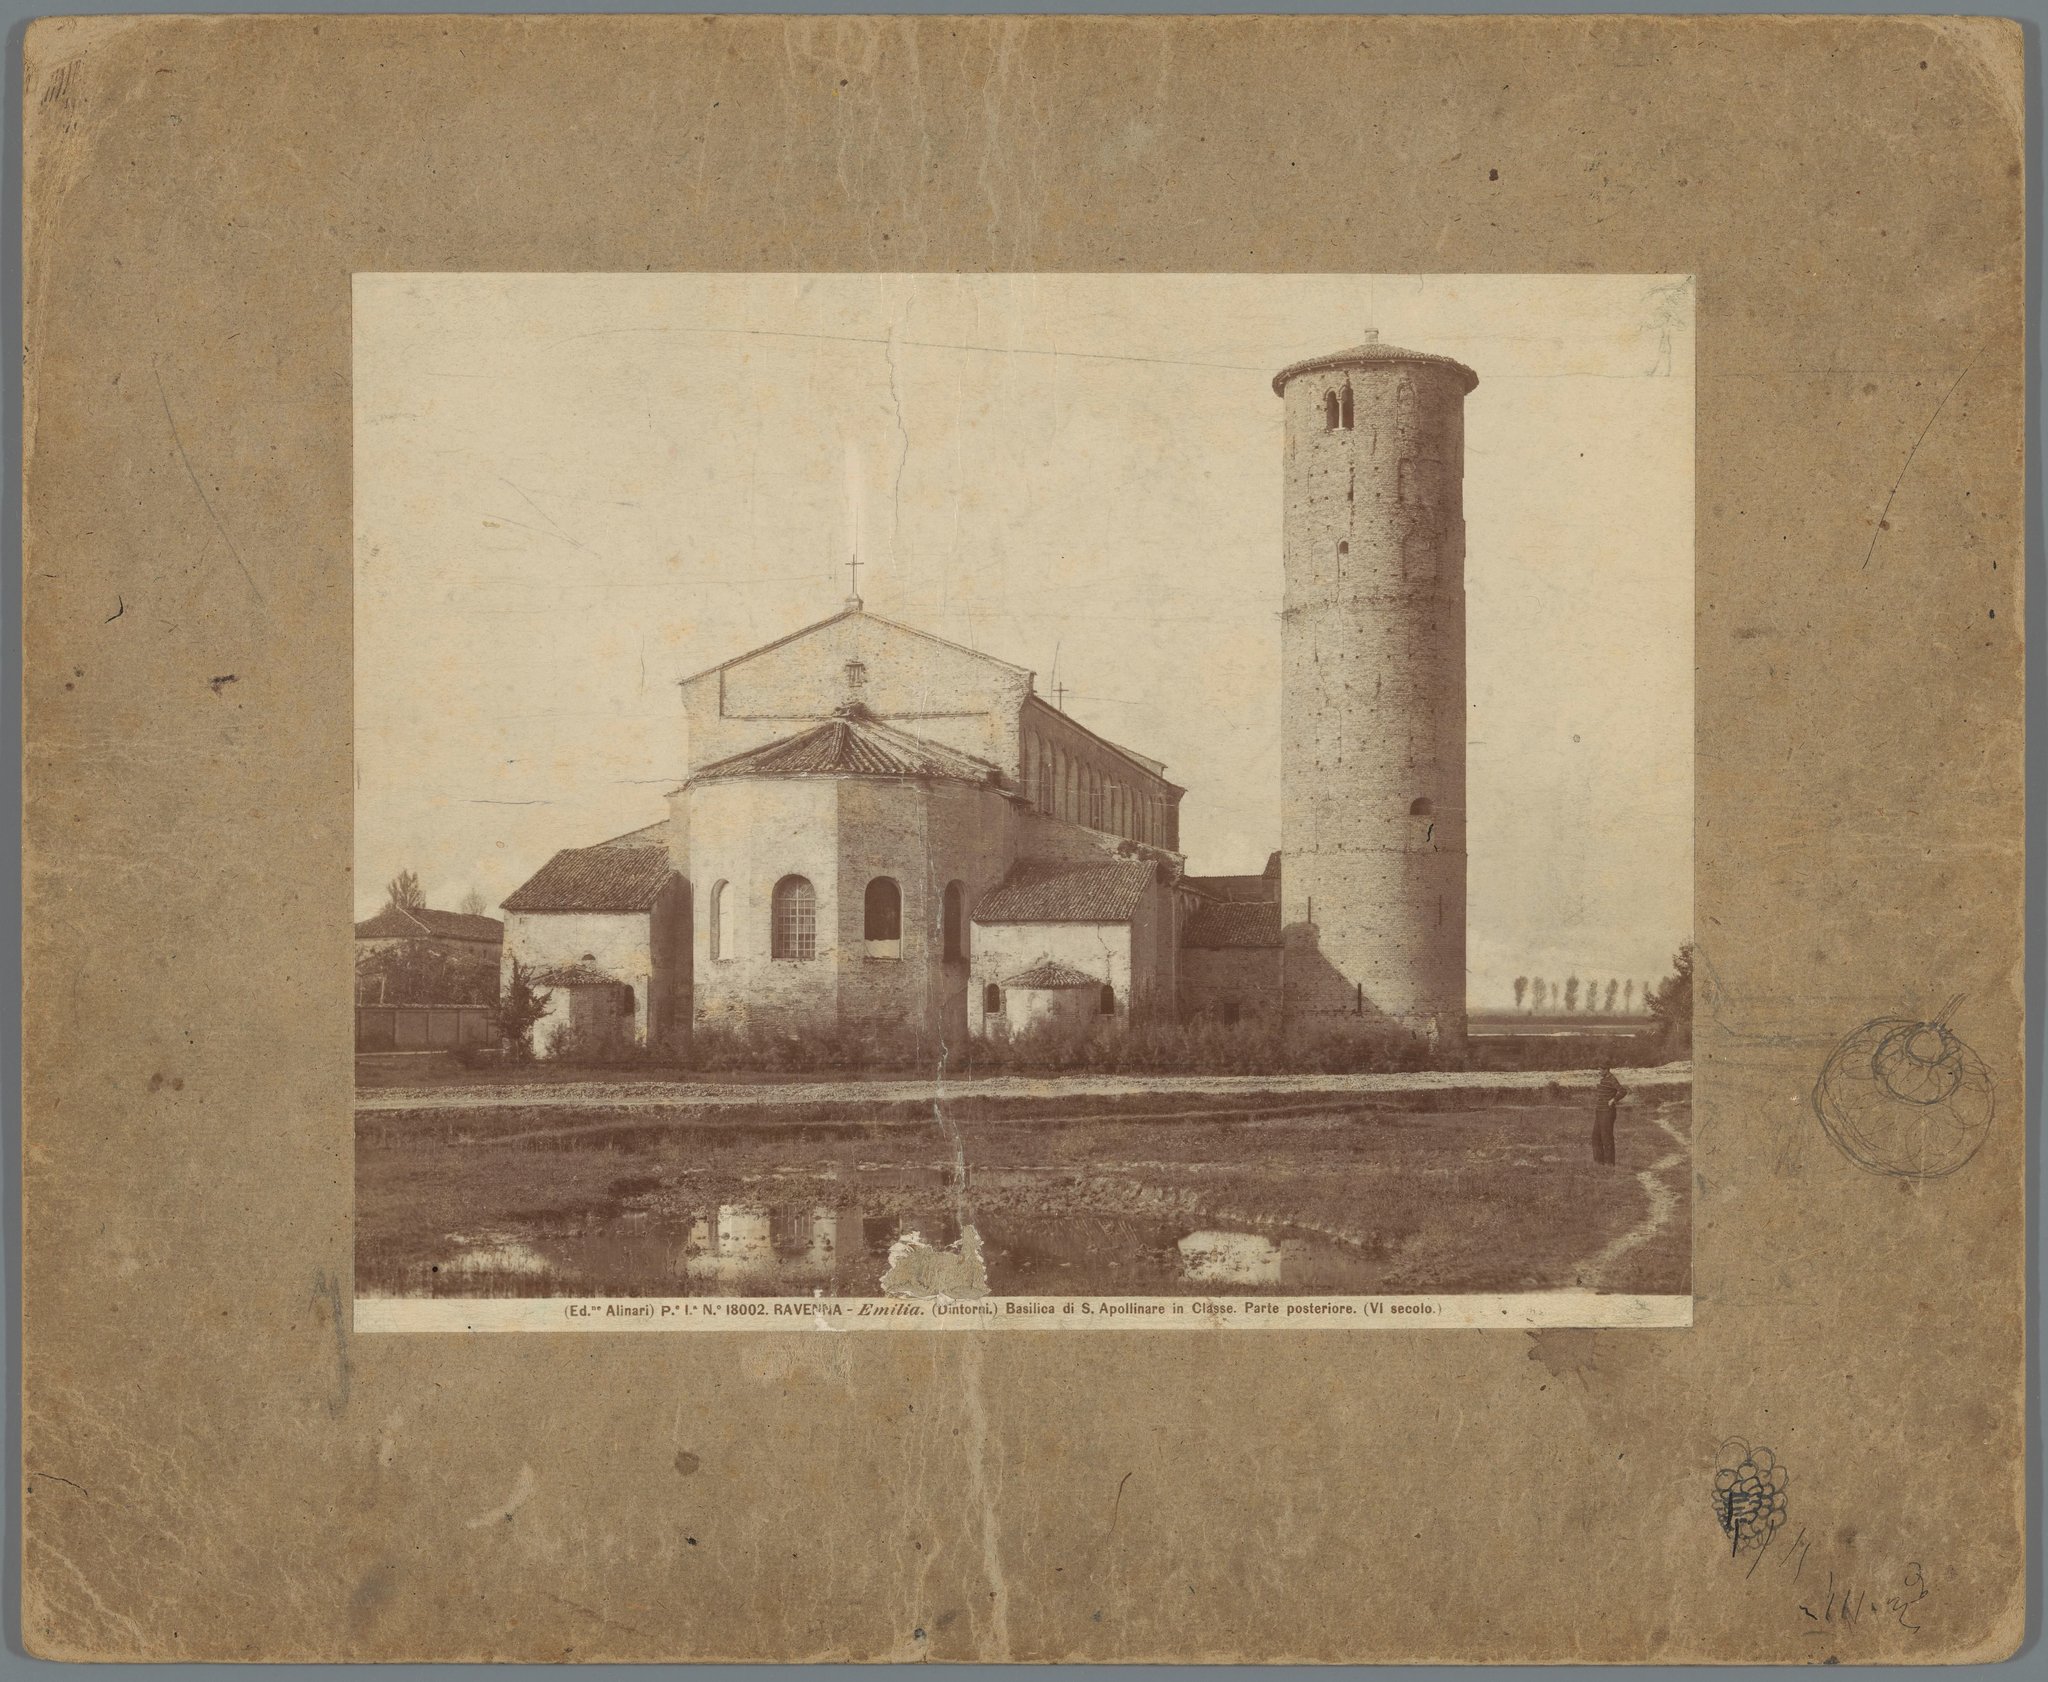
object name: photograph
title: Gezicht op de basiliek van Sant'Apollinare in Classe te Ravenna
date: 1875-1900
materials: cardboard, photographic support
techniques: albumen print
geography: ravenna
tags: tower, clock tower ~ monumental adornment, church (exterior)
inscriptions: annotation:, inscription: ‘O.C. 42.’, number: ‘P.e I.a N.o 18002.’, collector's mark: Lugt 3937